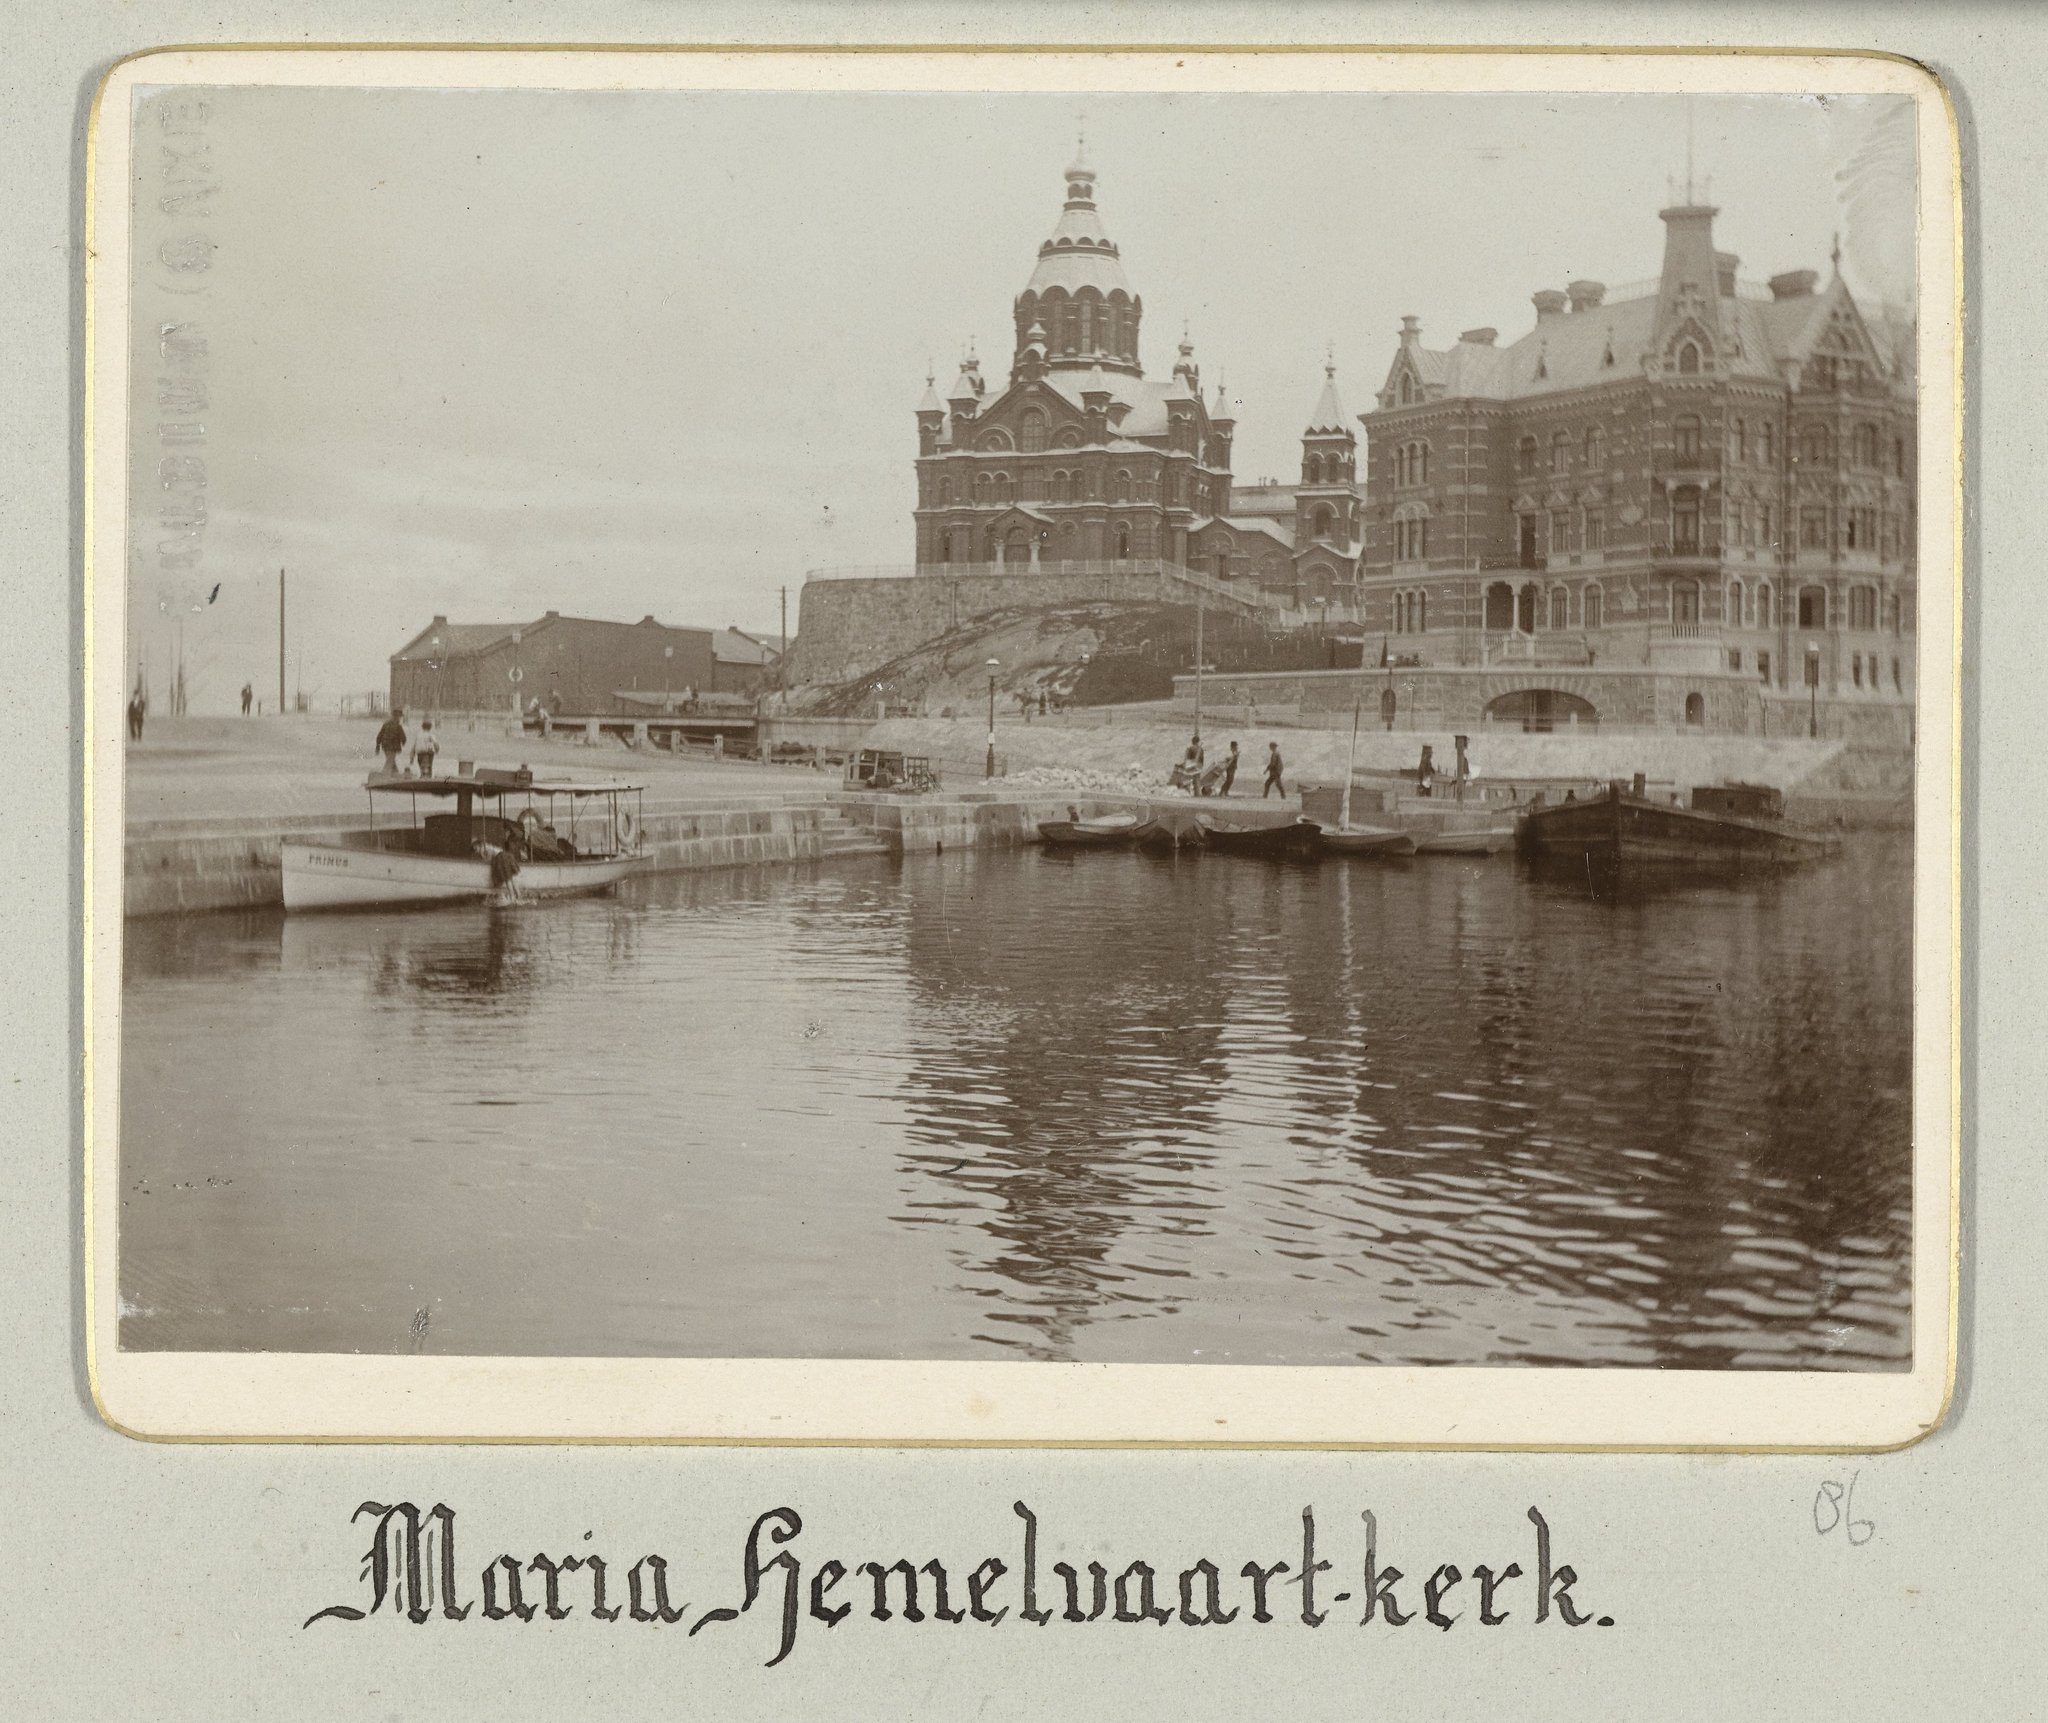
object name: photograph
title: Helsingfors Maria Hemelvaartkerk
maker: henry pauw van wieldrecht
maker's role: fotograaf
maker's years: 1863-1912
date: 1898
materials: paper, photographic support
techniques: albumen print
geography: helsinki